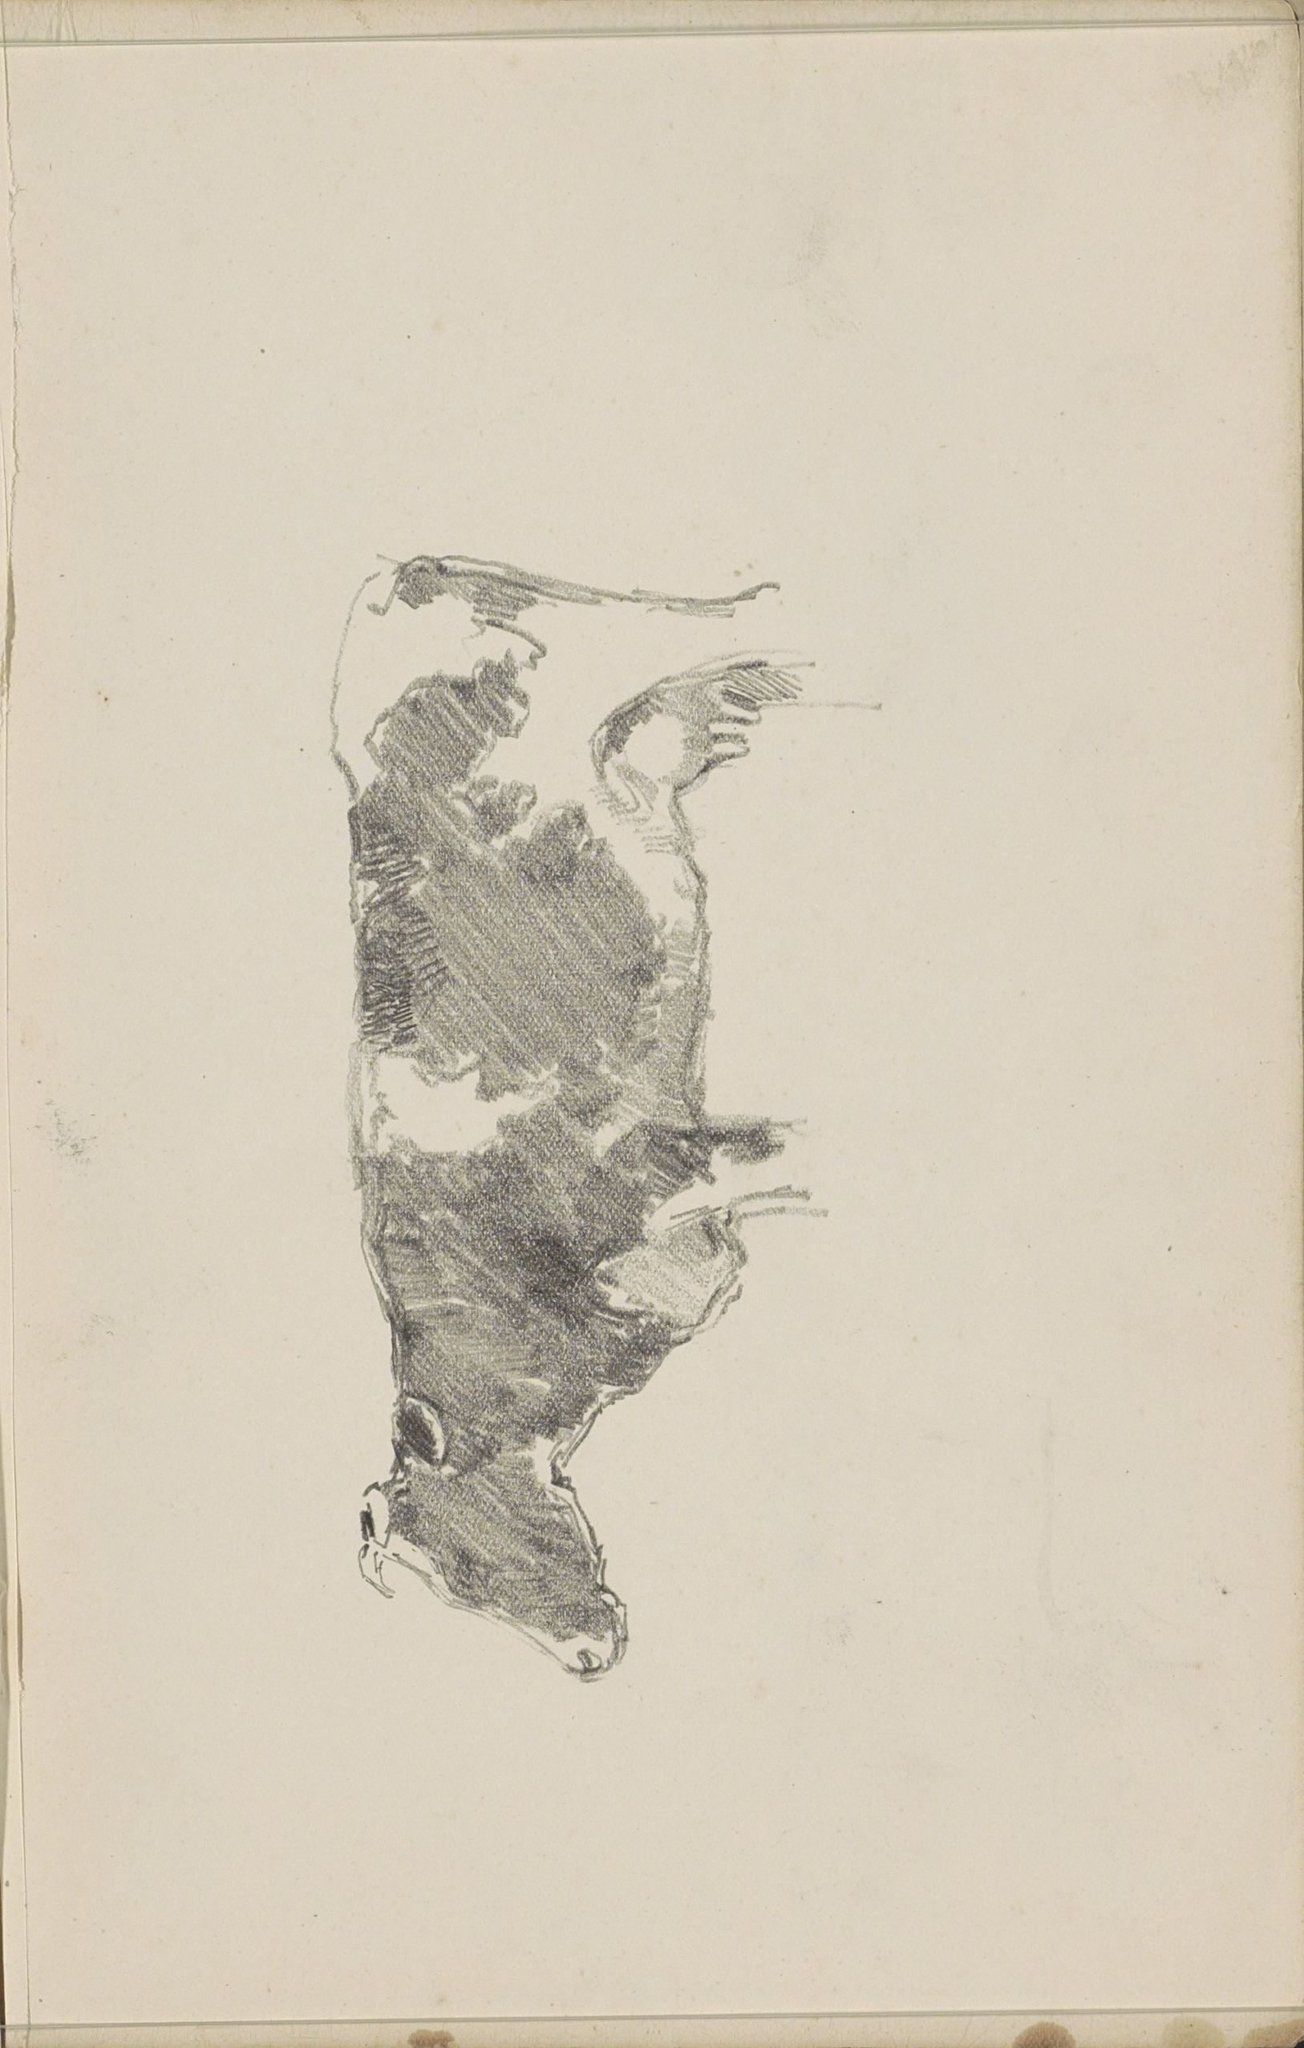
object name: sketchbook leaf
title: Koe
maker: cornelis vreedenburgh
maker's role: draughtsman, print maker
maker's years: 1880-1946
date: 1890-1946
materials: chalk, paper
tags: cow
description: Blad 10 recto uit een schetsboek met 45 bladen.